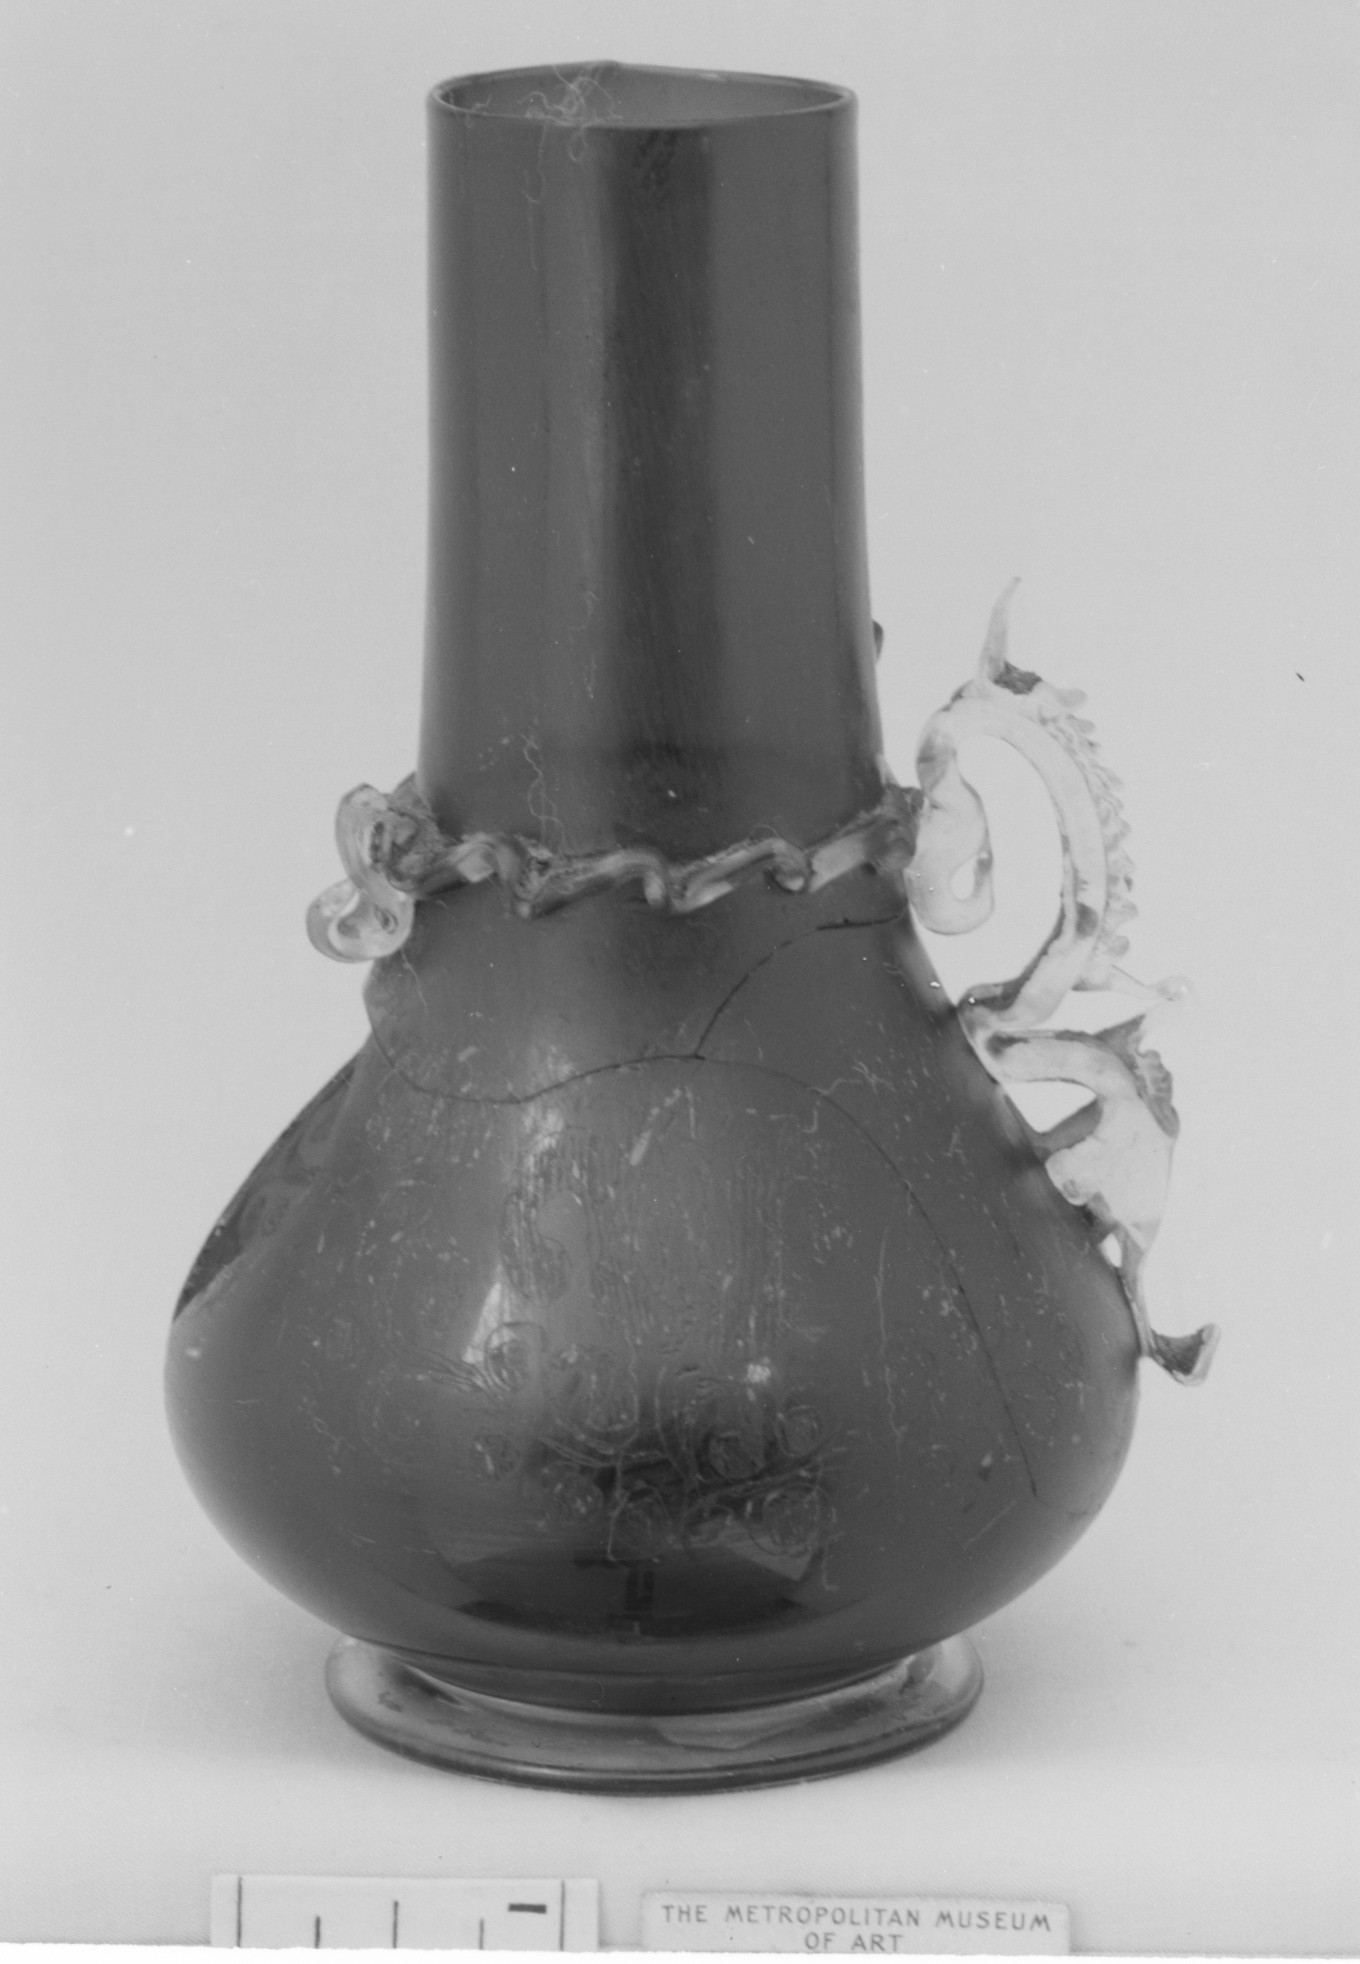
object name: vase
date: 1601-1700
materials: glass